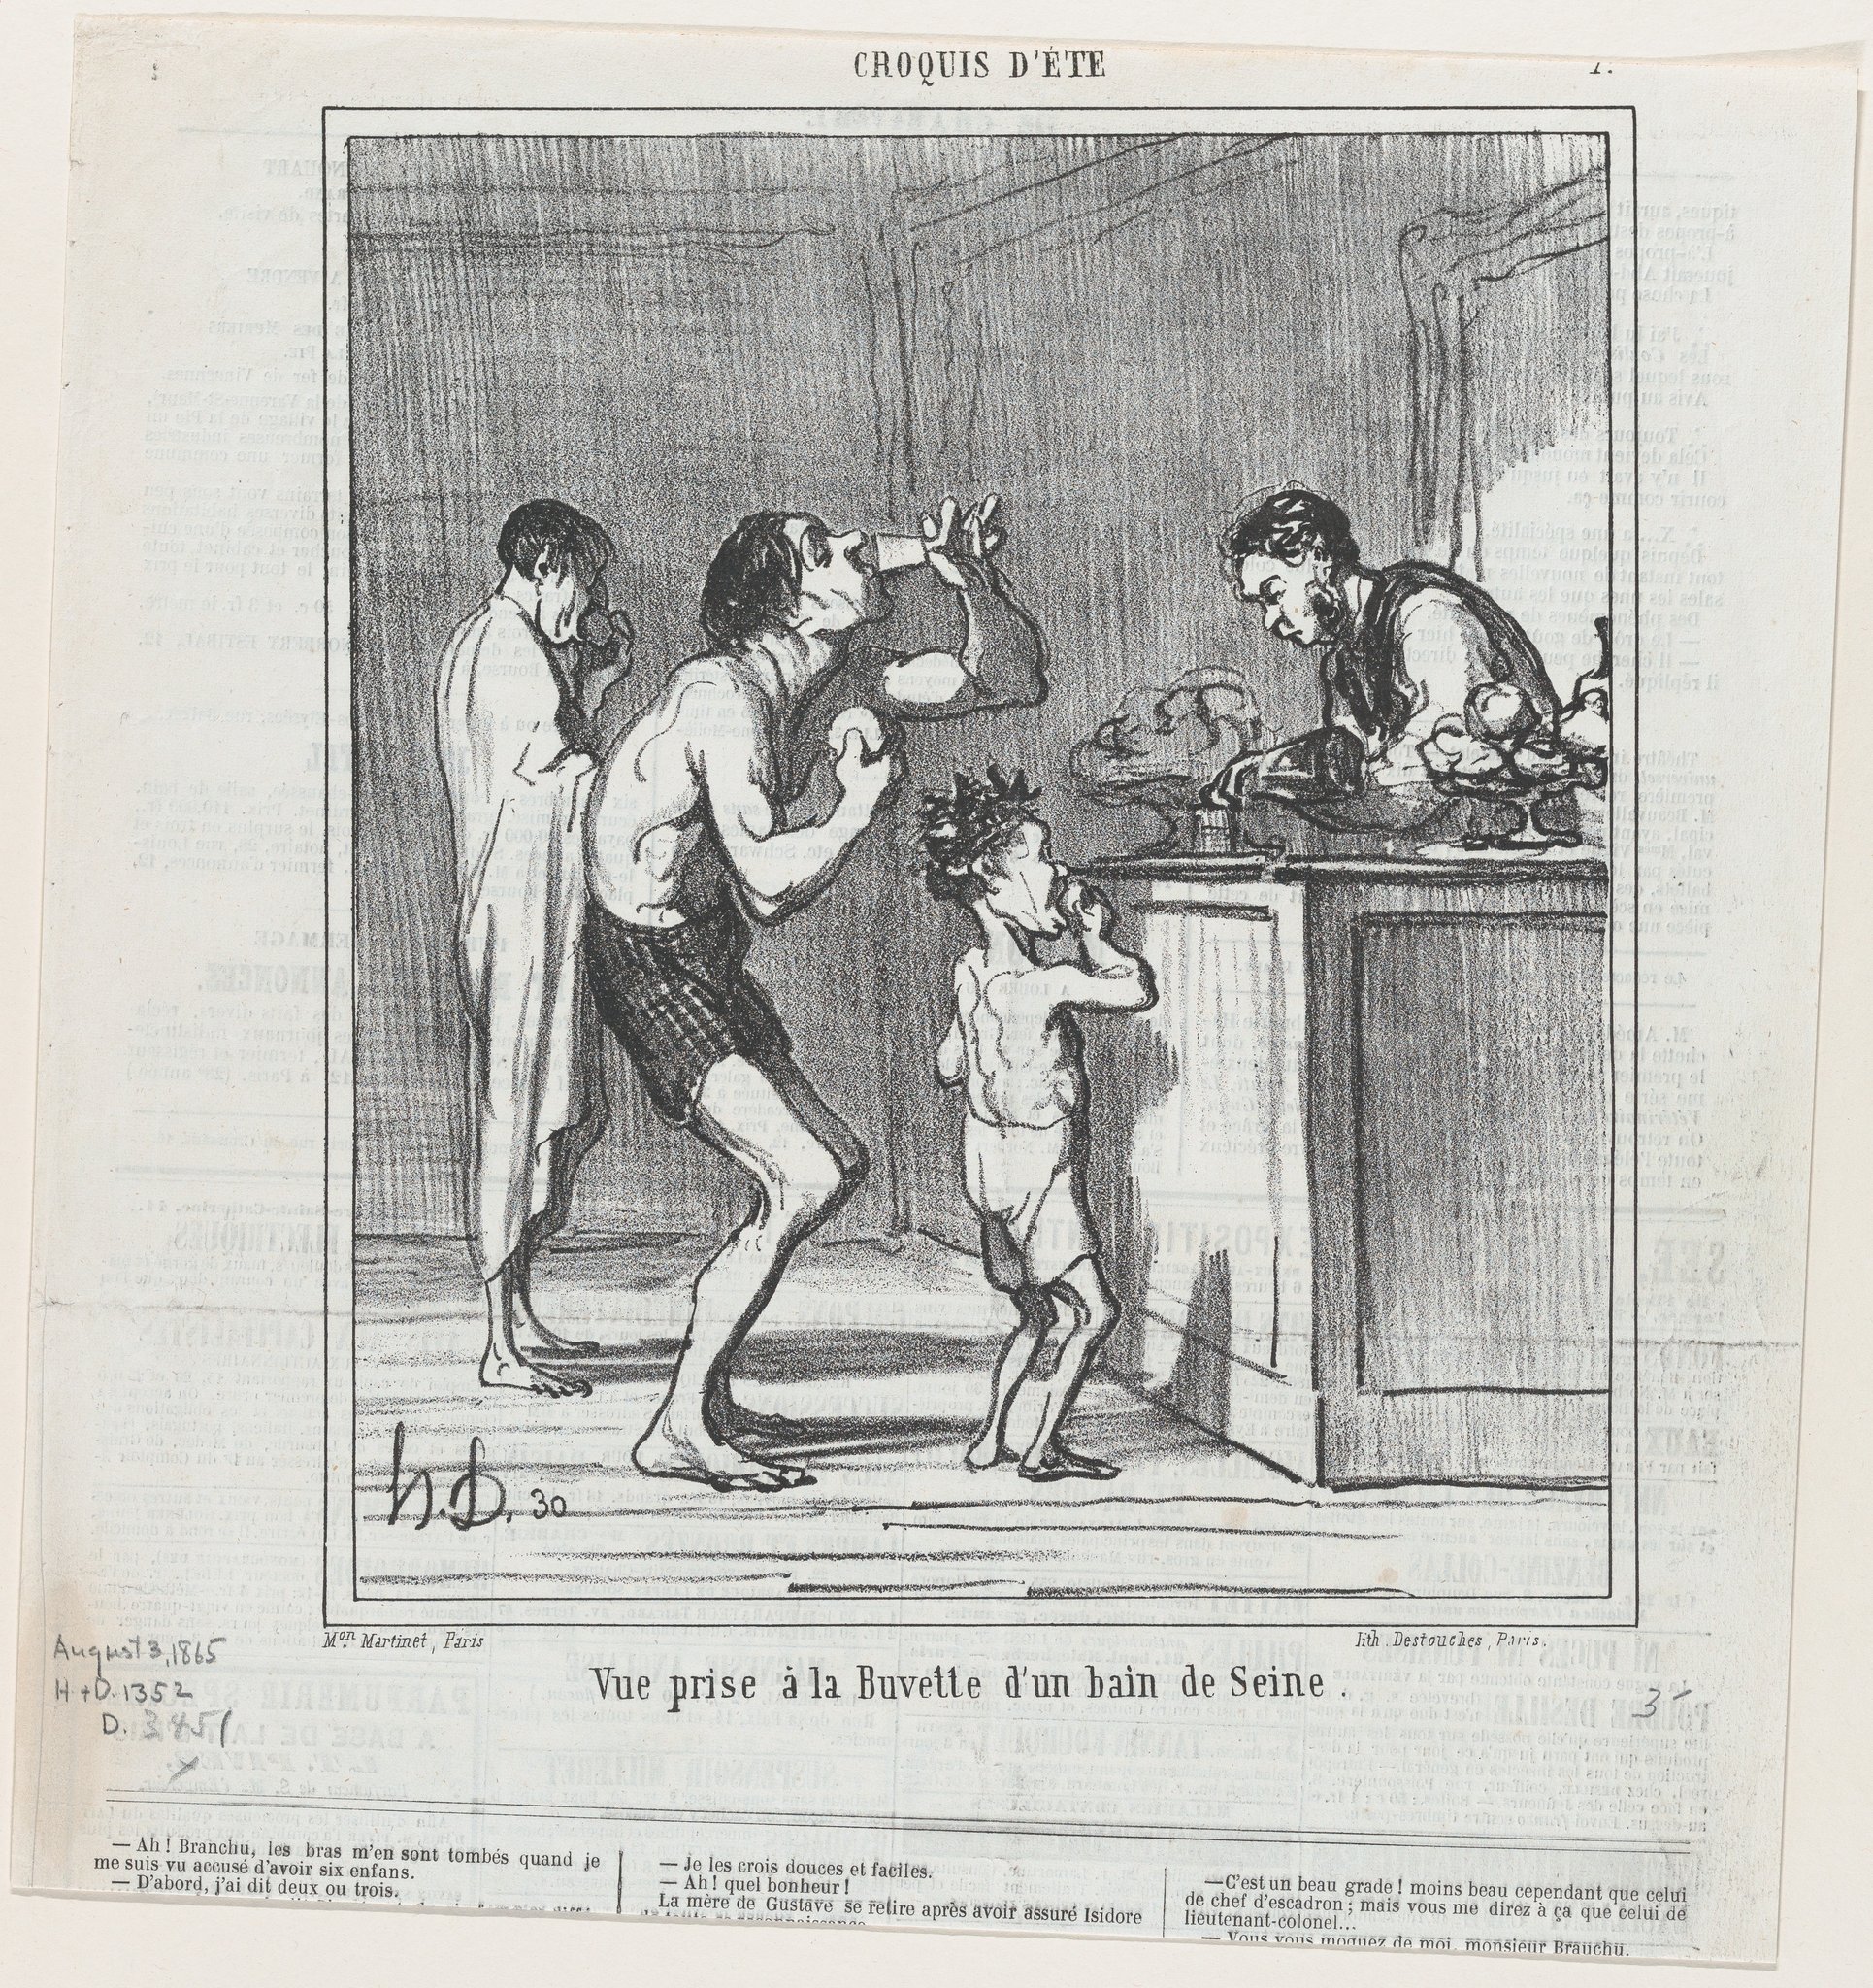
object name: print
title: View of a refreshment stand at a bath on the Seine, from 'Summer sketches,' published in Le Charivari, August 3, 1865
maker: honoré daumier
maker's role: artist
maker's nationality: french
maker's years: 1808-1879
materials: paper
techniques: lithograph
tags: men,drinking